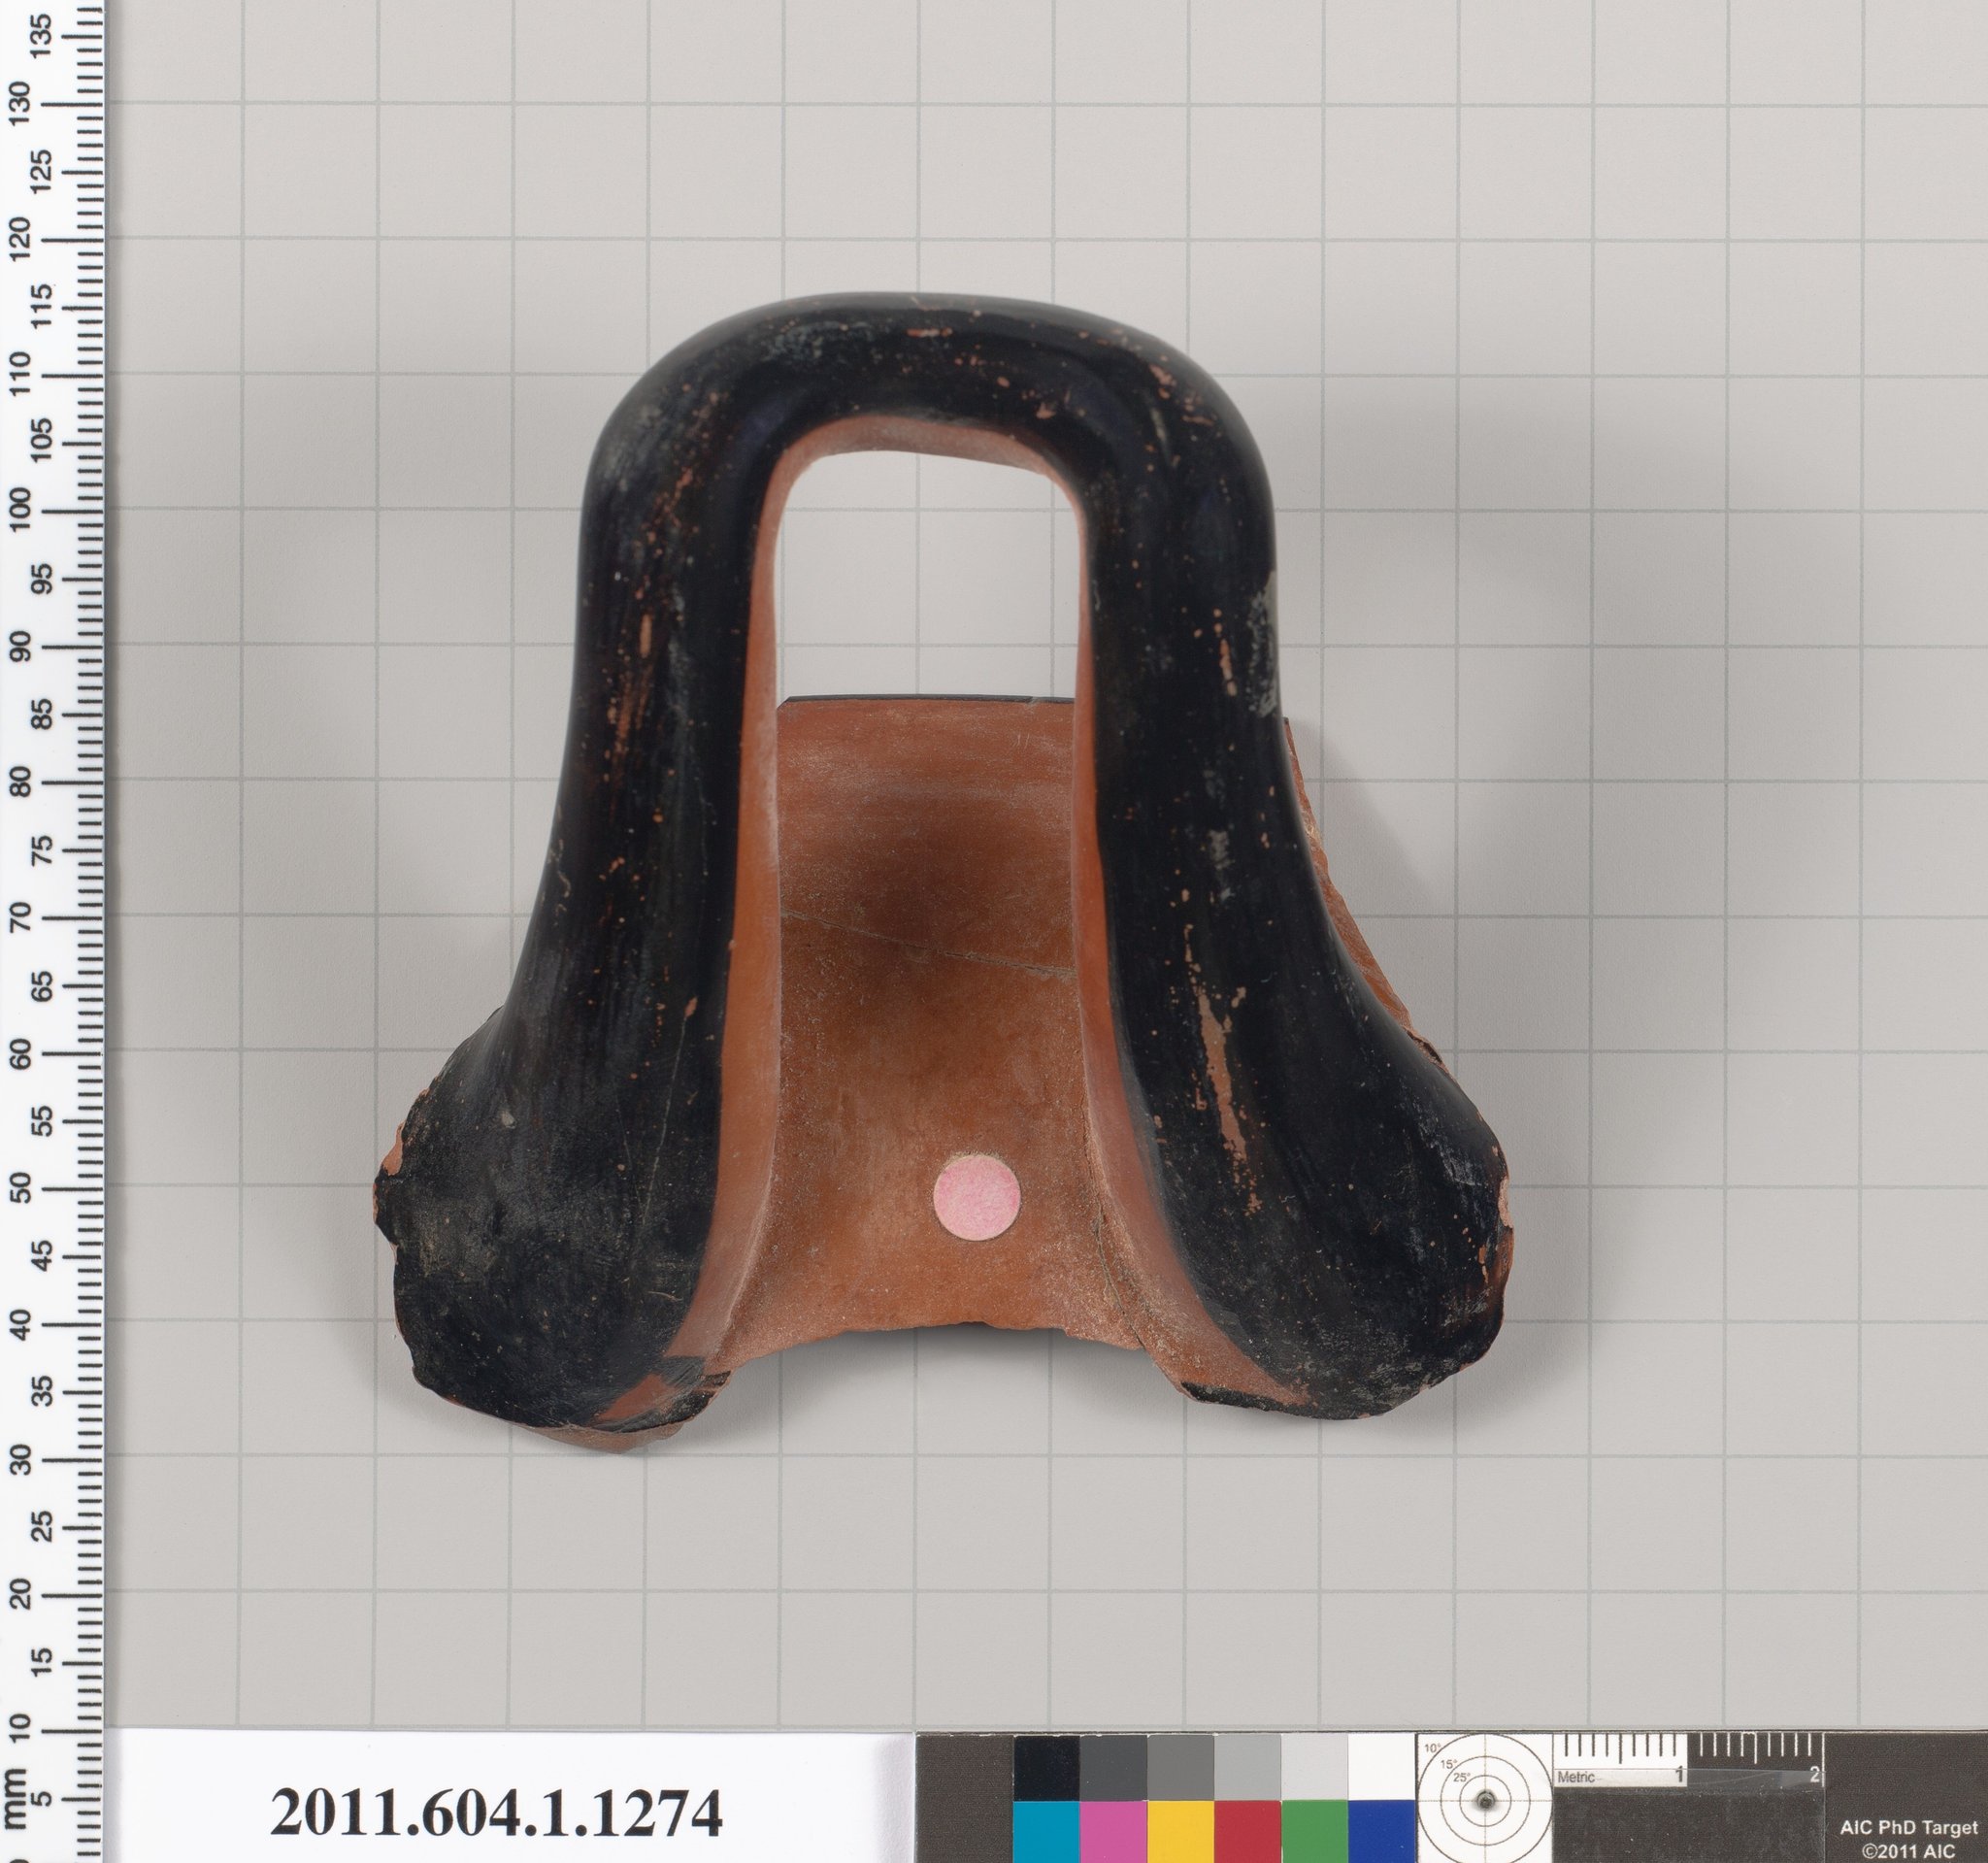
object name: kylix fragment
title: Terracotta fragment of a kylix (drinking cup)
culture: greek, attic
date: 500-401 BCE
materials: terracotta